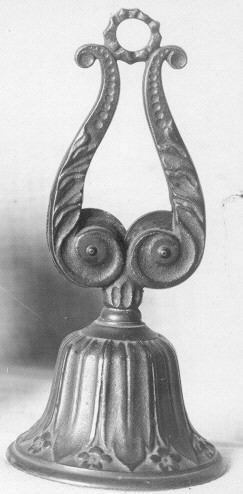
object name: hand bell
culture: european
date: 1801-1900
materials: metal